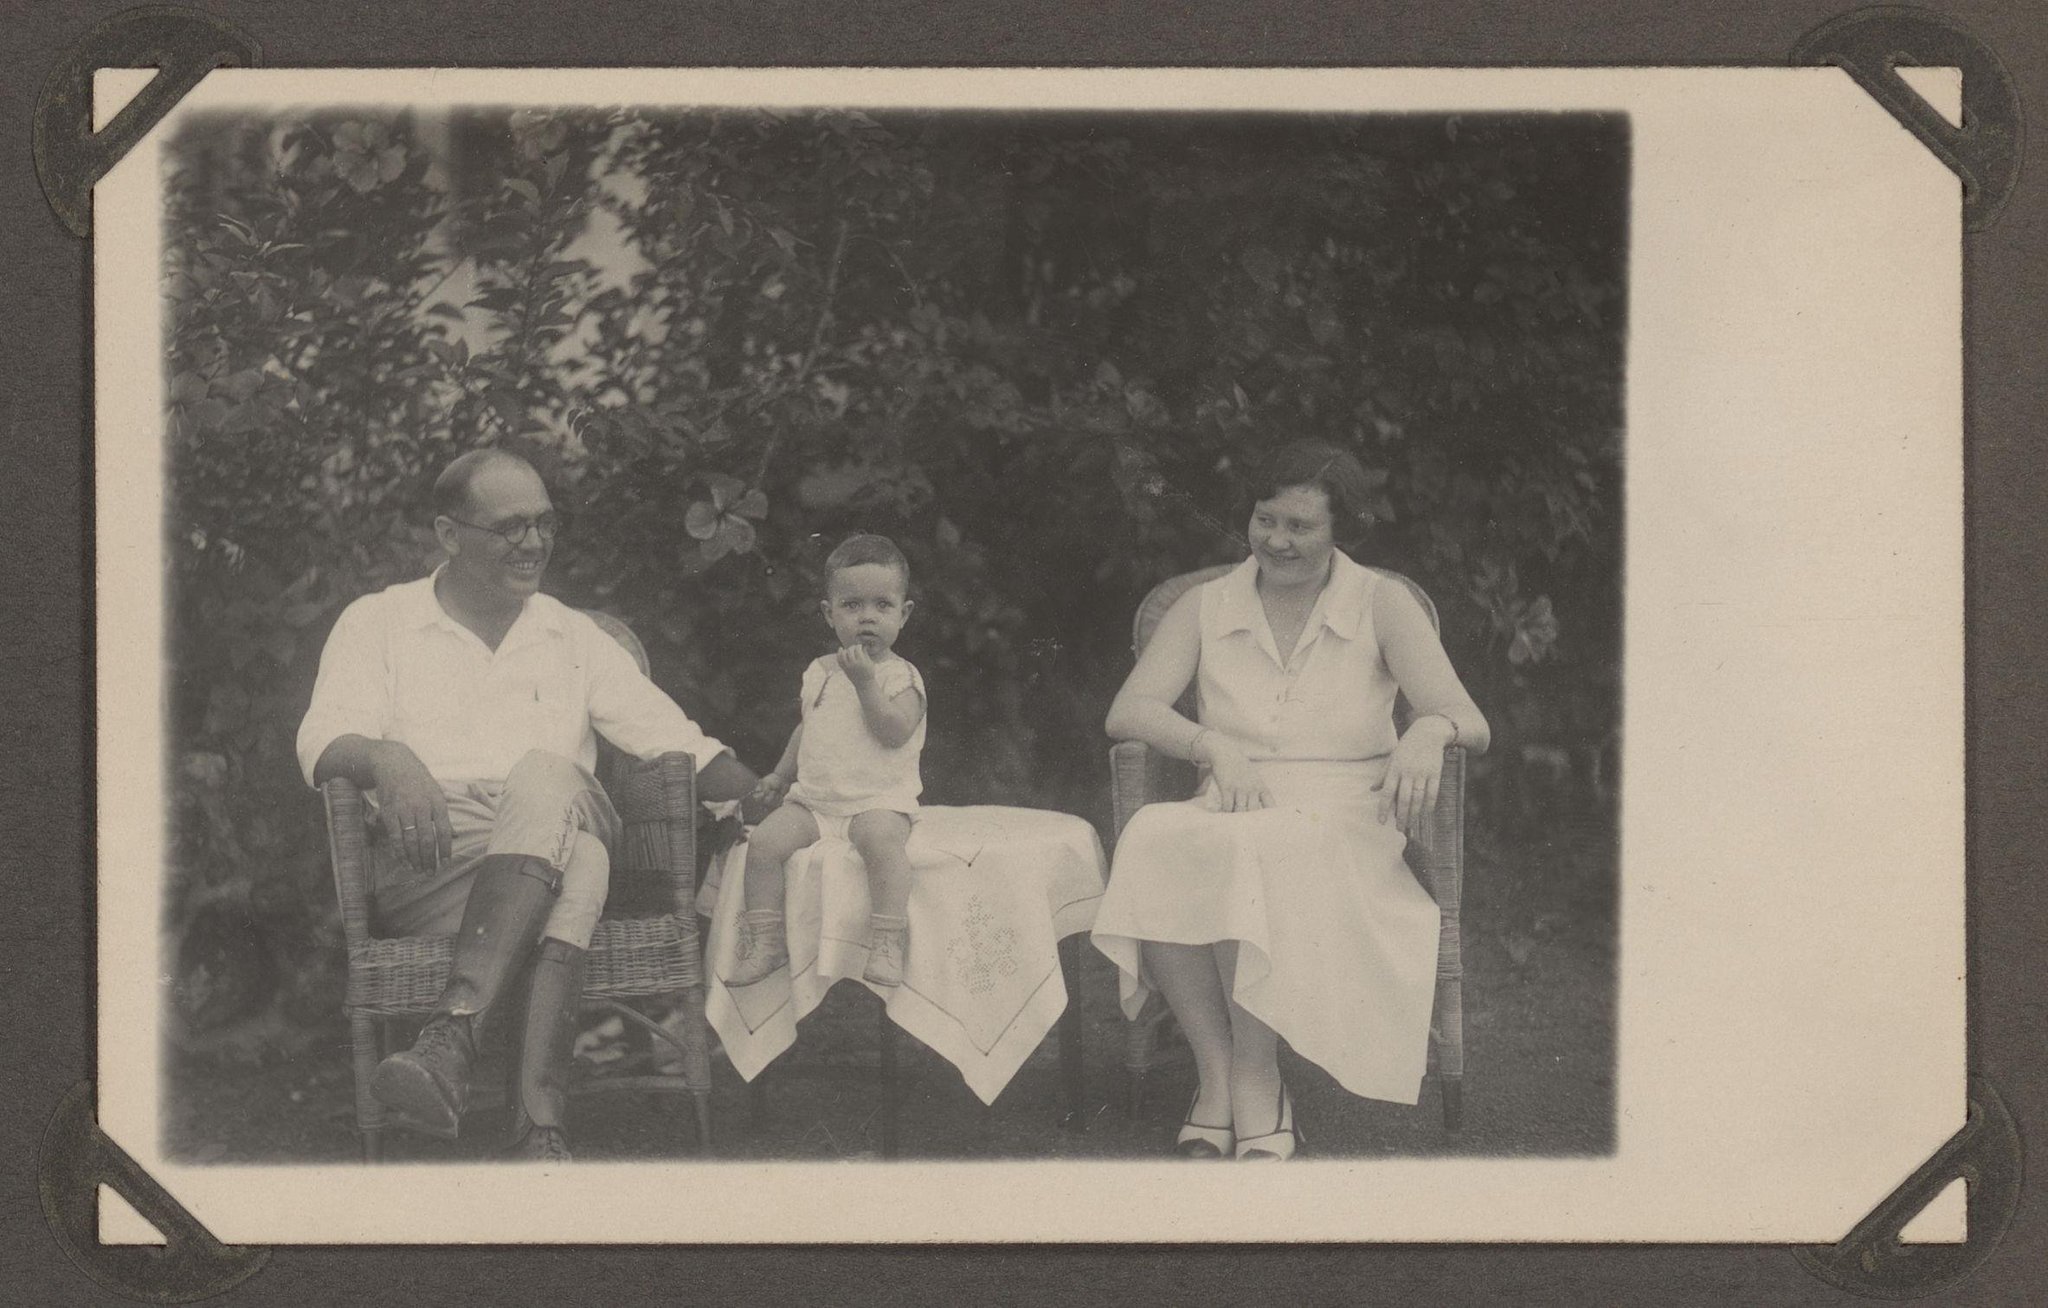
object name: photograph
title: Familiefoto van het gezin Jetten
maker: Anonymous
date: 1925-1927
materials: photographic support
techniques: photography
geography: suriname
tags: jetten, familie, moengo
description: Familiefoto van de kinderen Jetten, soms met de ouders. Foto op een bladzijde van een los albumblad. Onderdeel van het ensemble met foto's van de familie van ingenieur Jetten in de mijnbouwstad Moengo in Suriname.